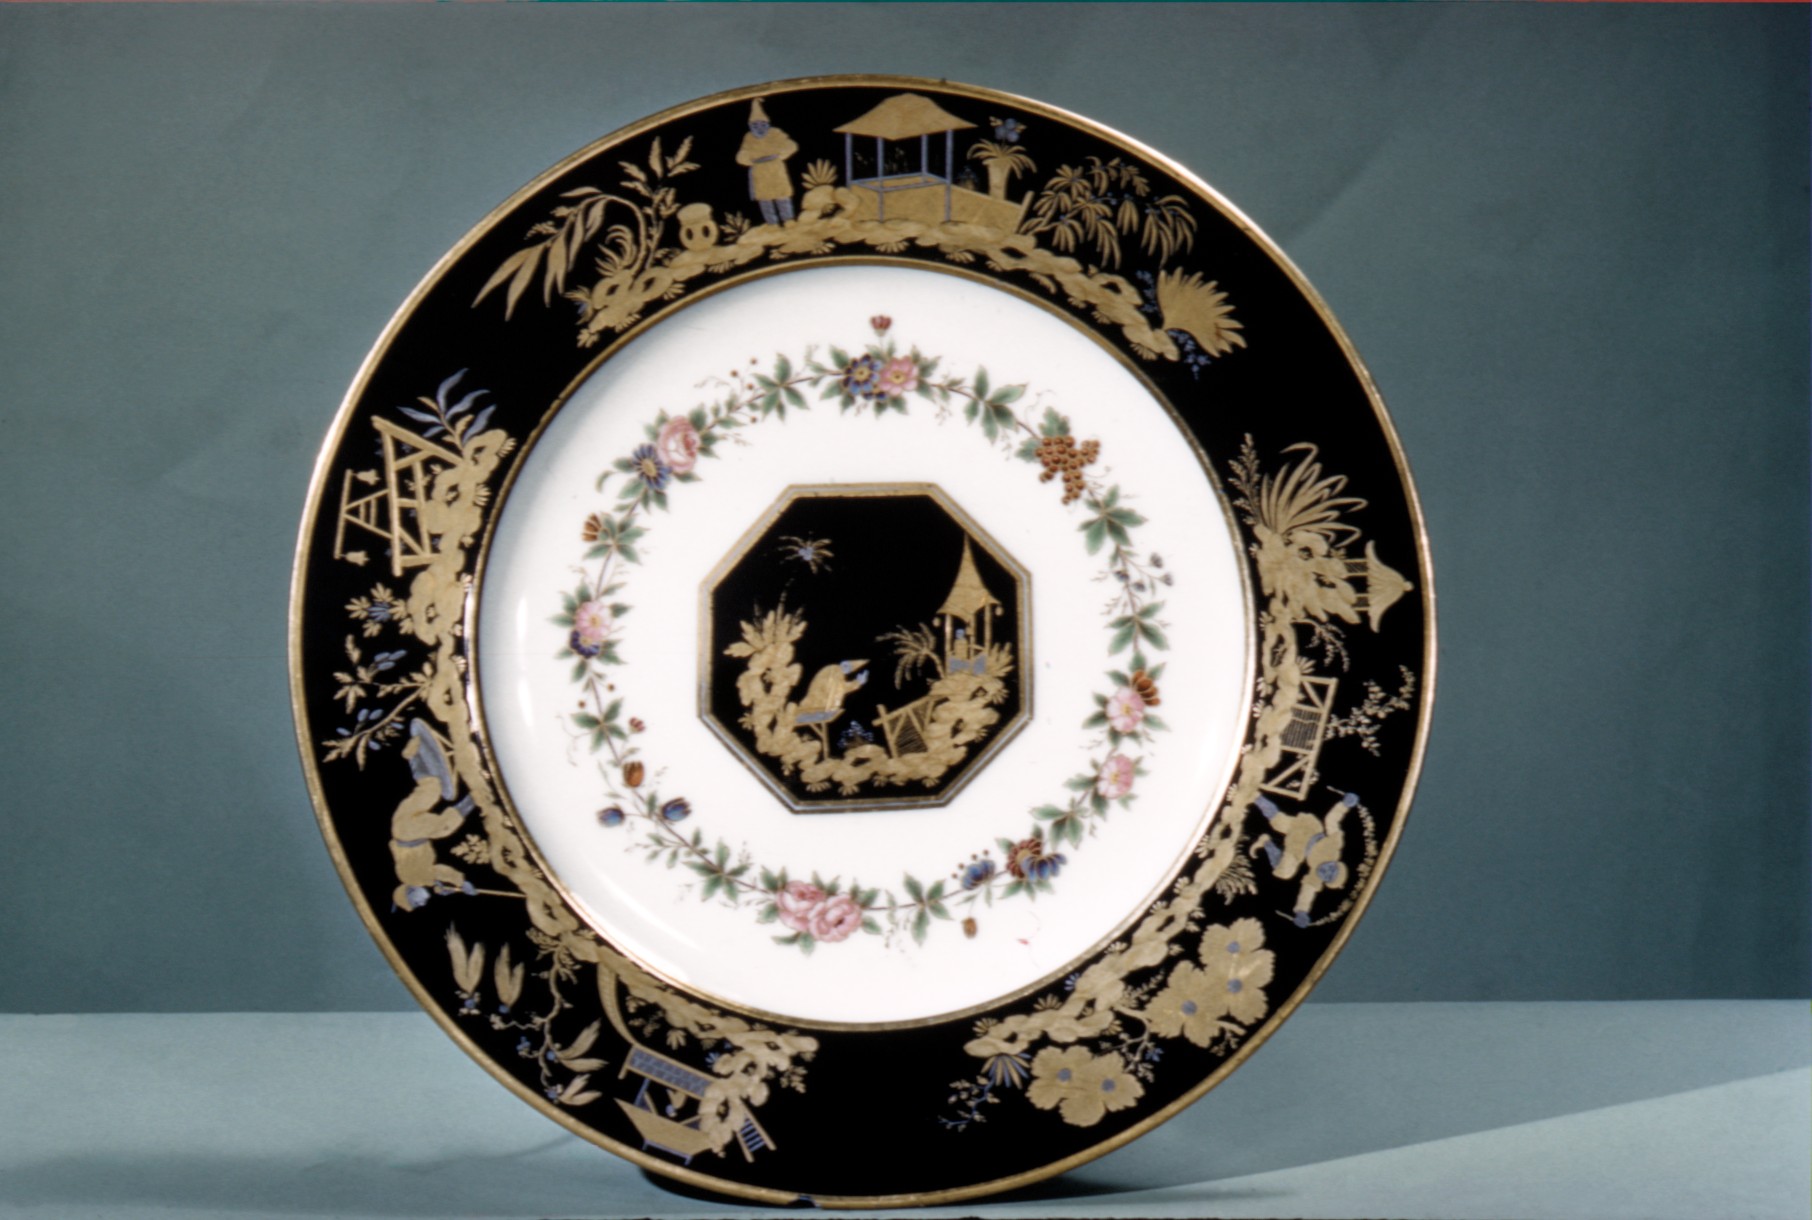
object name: plate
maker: sèvres manufactory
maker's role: manufactory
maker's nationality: french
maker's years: 1740-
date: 1791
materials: hard paste porcelain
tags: men,flowers